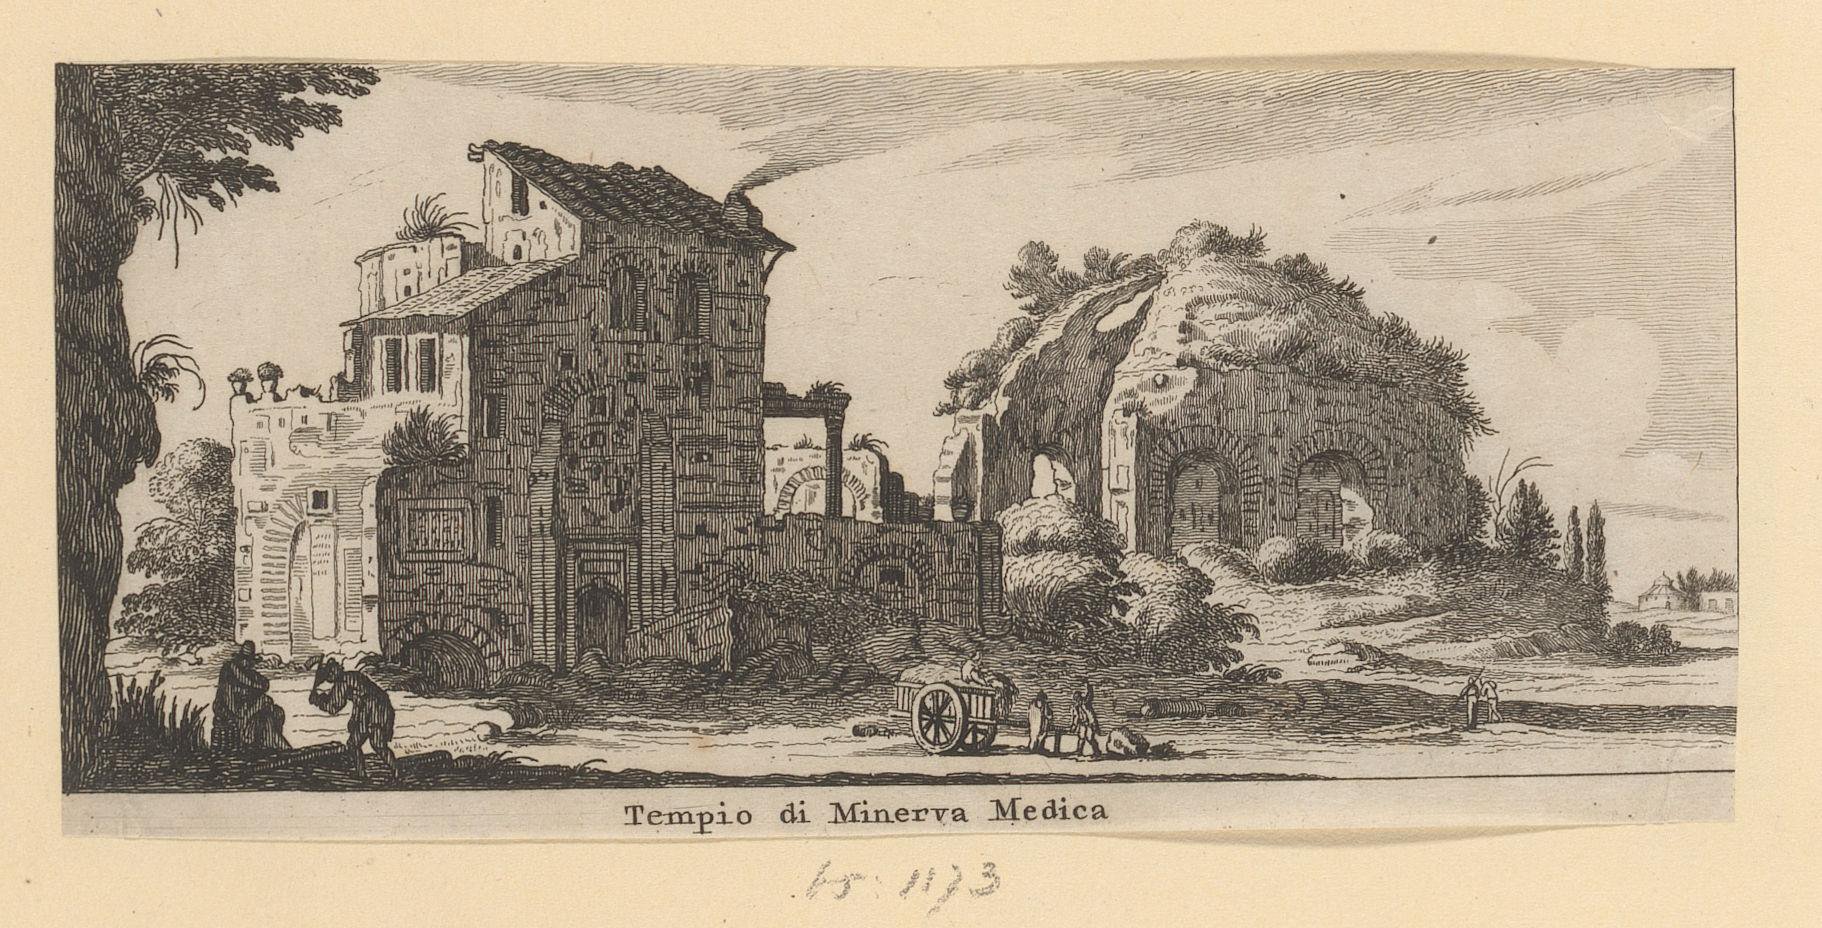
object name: print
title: Antiche et moderne vedute di Romae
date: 1638-1799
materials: paper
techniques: etching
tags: landscape with ruins (+ city(-scape) with figures, staffage)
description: Prent maakt mogelijk deel uit van een serie van 200 prenten. Deze serie is onder de titel 'A Collection of two hundred original etchings' voor het eerst uitgegeven door J.M. Greery in 1816.